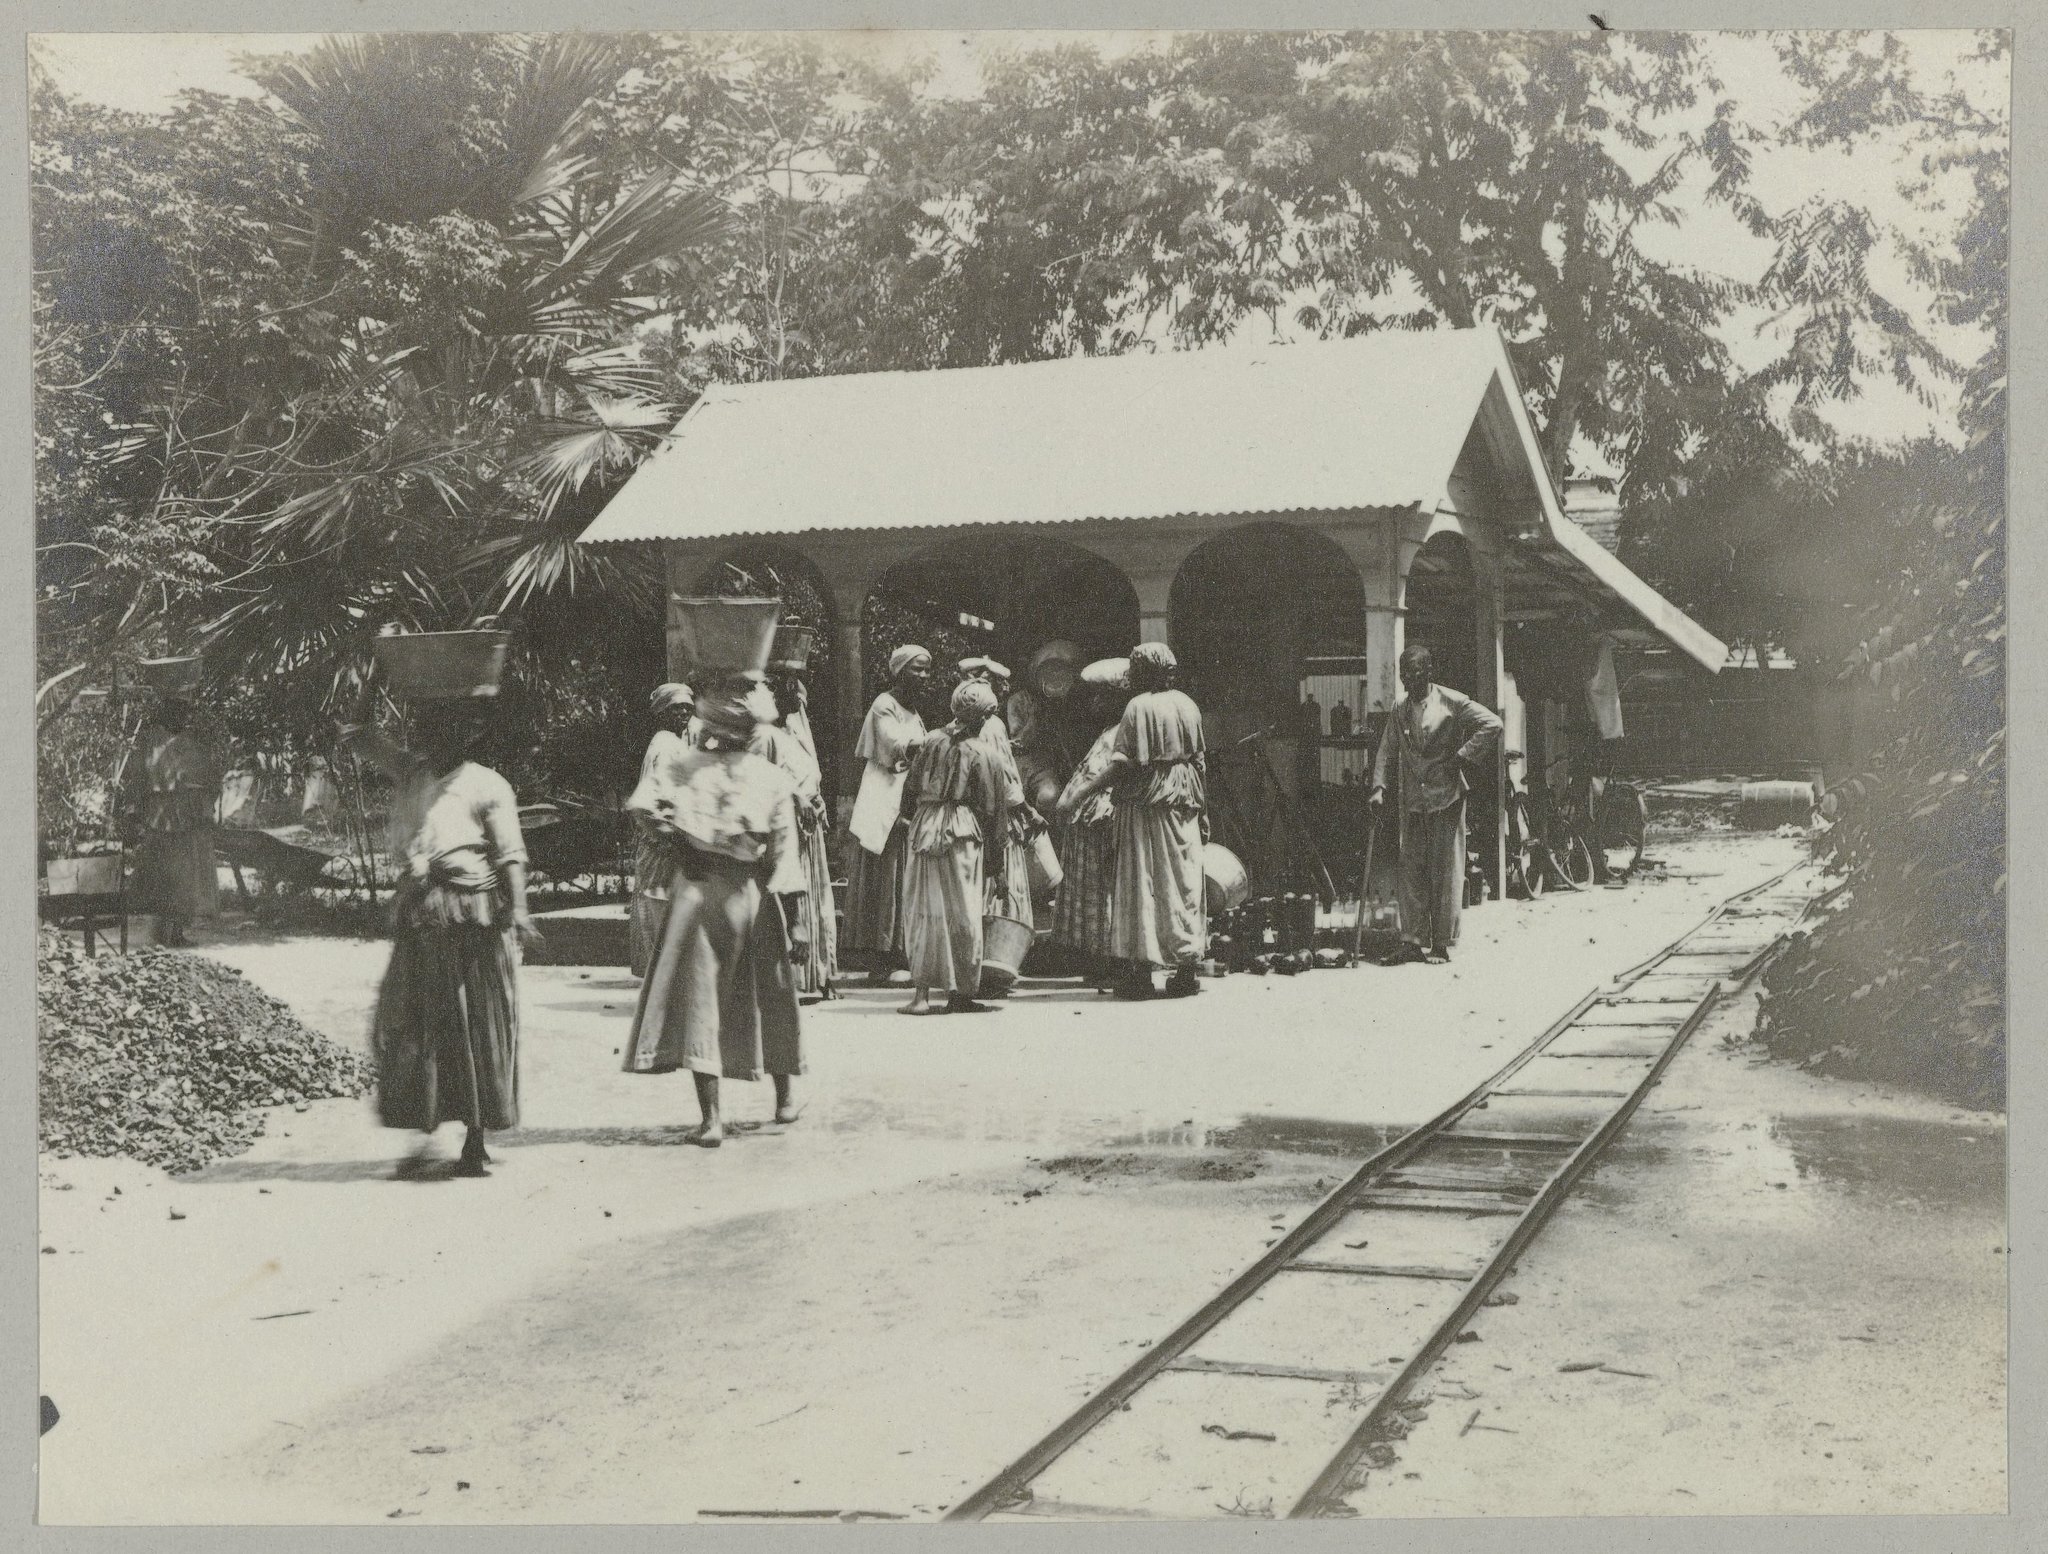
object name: photograph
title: Waterhalen voor gieten hospitaalreservoir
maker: hendrik doijer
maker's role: engineer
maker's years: 1863-1925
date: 1903-1910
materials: photographic support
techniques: gelatin silver print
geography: suriname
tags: suriname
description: Een groep Surinaamse vrouwen dragen kruiken met water op hun hoofd voor het hospitaalreservoir, waarschijnlijk te Paramaribo. Onderdeel van het fotoalbum Souvenir de Voyage (deel 5), over het leven van de familie Doijer in en rond de plantage Ma Retraite in Suriname in de jaren 1903-1910.